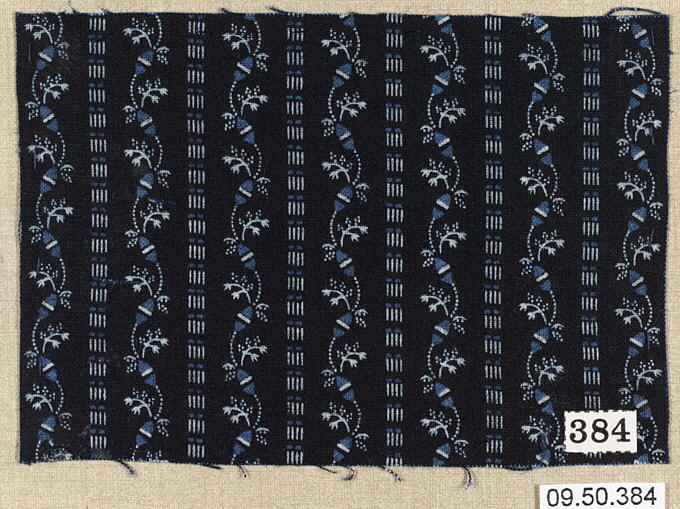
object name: piece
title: Piece (one of 116)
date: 1801-1900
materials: cotton